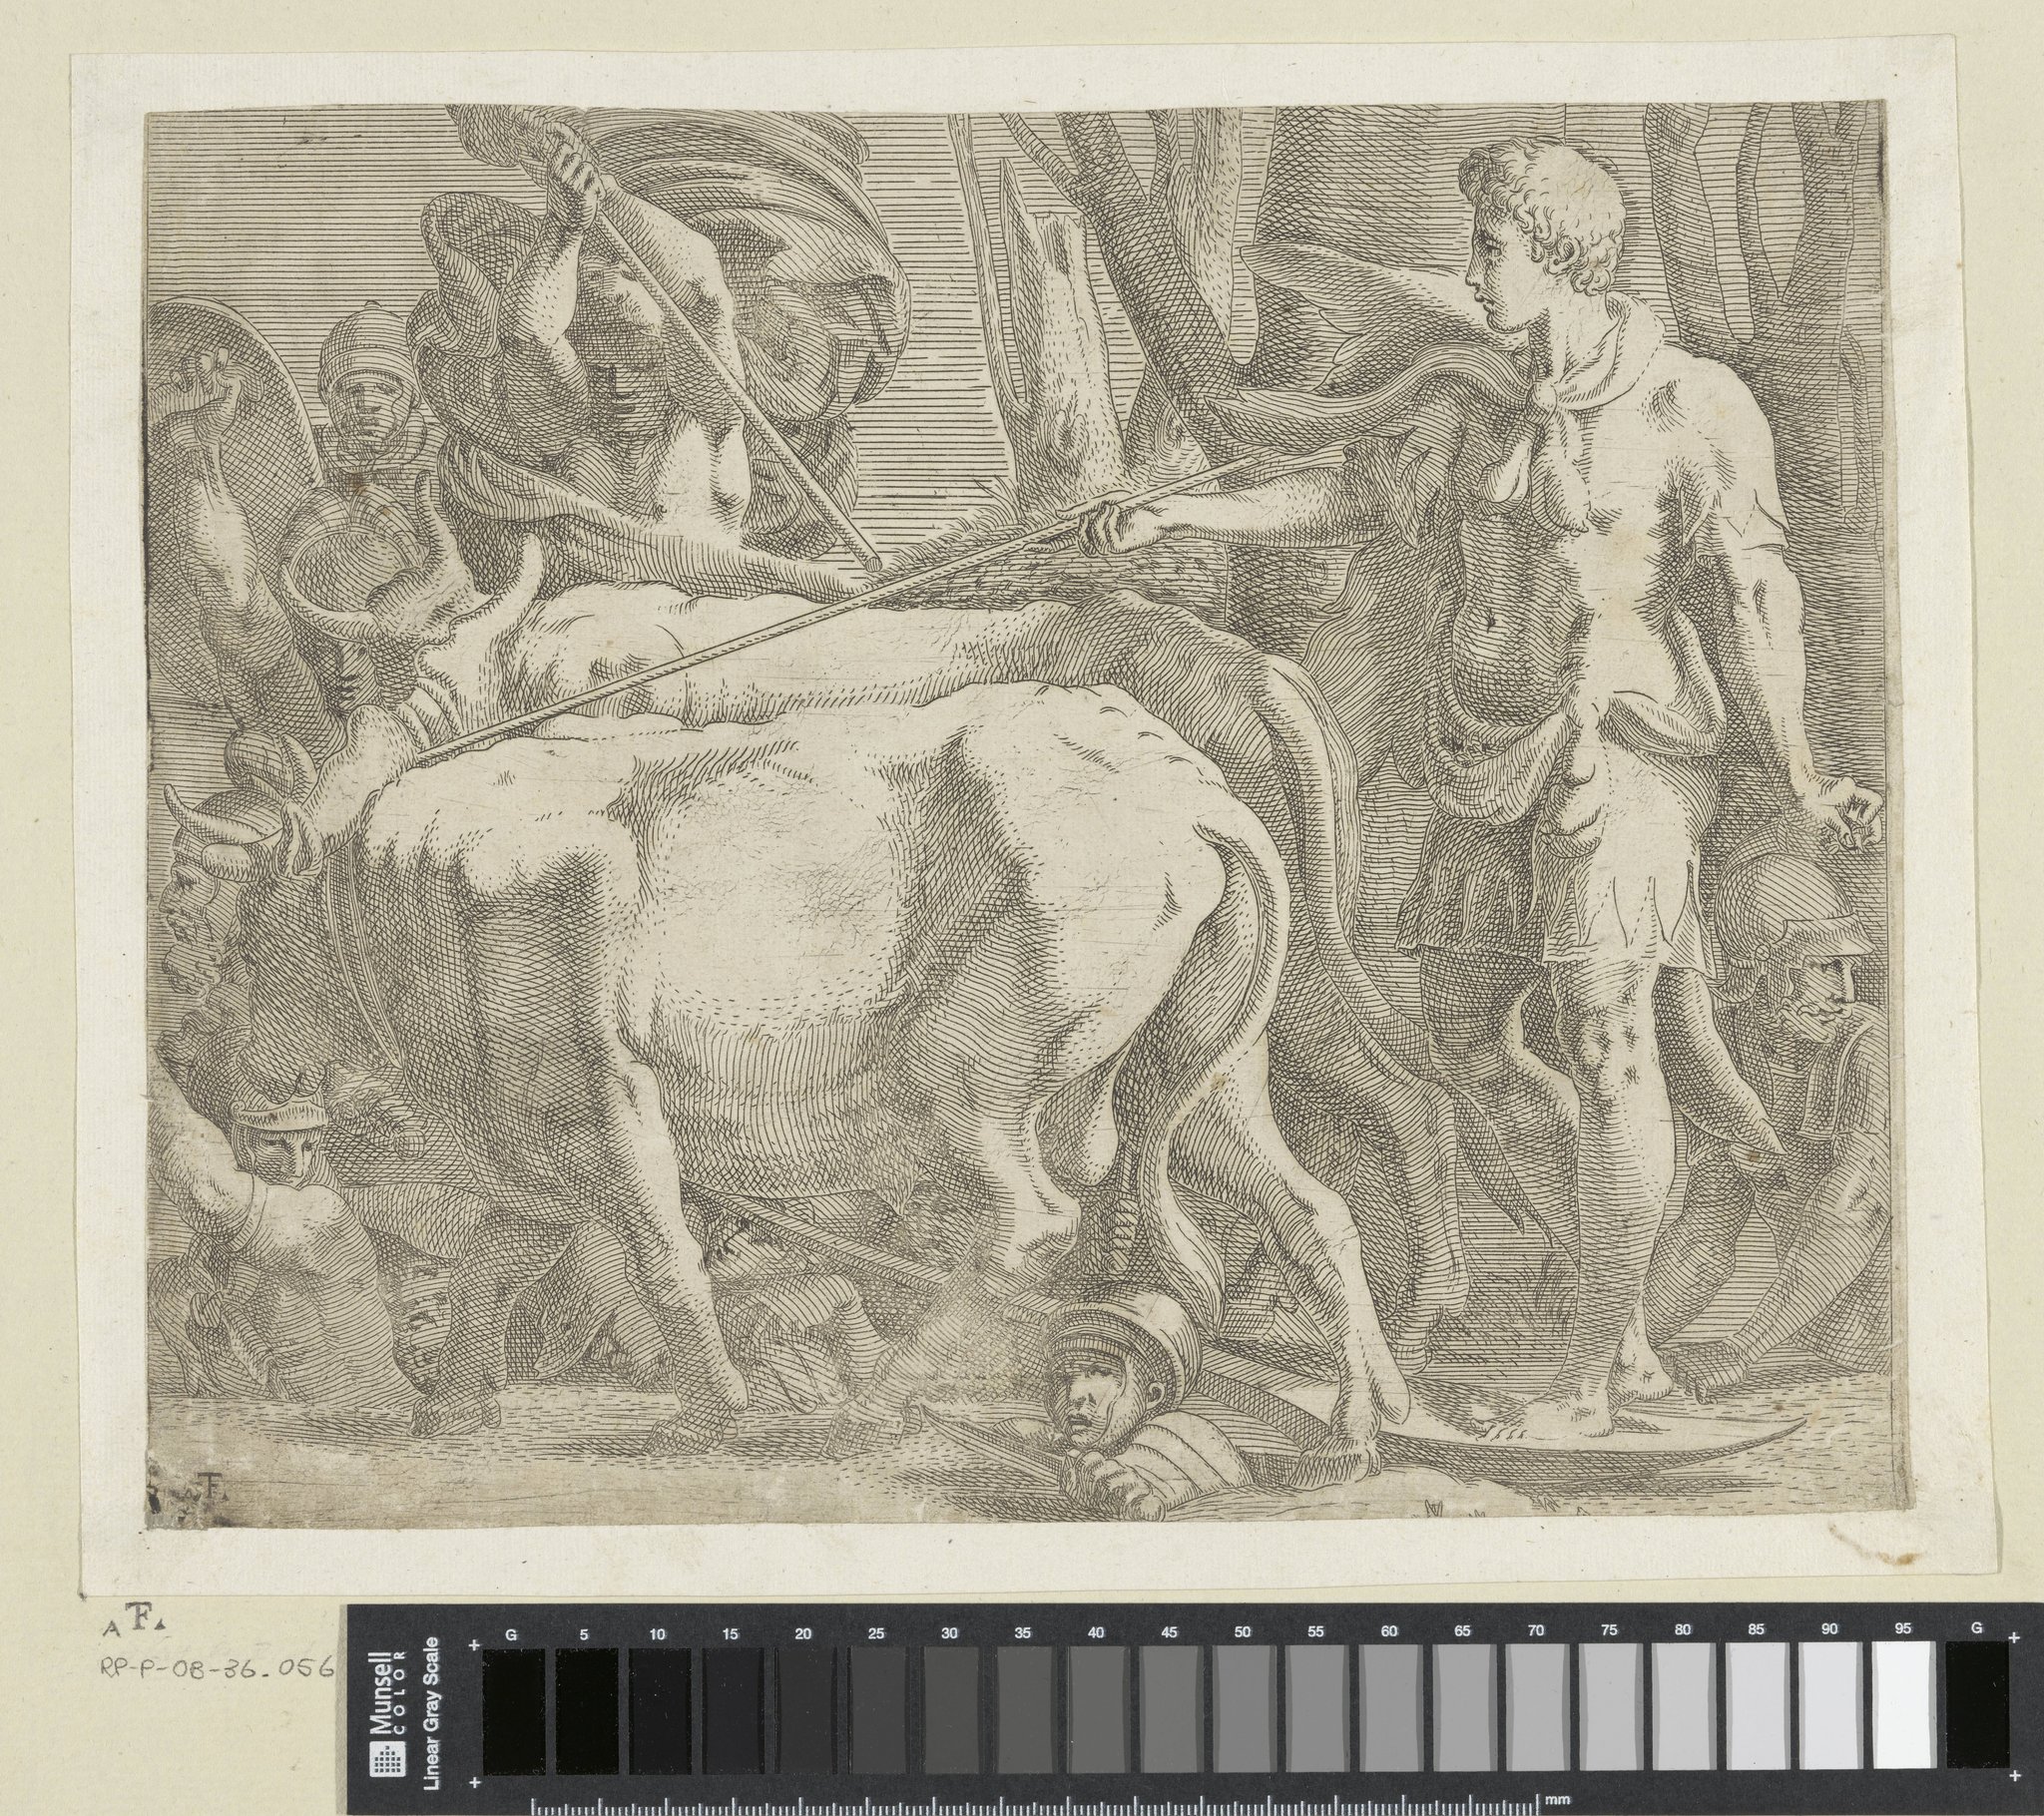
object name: print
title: Jason ploegt het veld waar hij drakentanden gezaaid heeft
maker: antonio fantuzzi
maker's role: painter, print maker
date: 1544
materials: paper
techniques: etching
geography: fontainebleau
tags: jason hitches the fire-breathing bulls to the plough, after ploughing, jason sows dragon's teeth; armed men emerge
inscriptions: collector's mark: Lugt 240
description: Jason ploegt met behulp van twee getemde ossen een veld. In het veld heeft hij drakentanden gezaaid. Deze drakentanden zijn veranderd in soldaten die nu uit de grond kruipen.